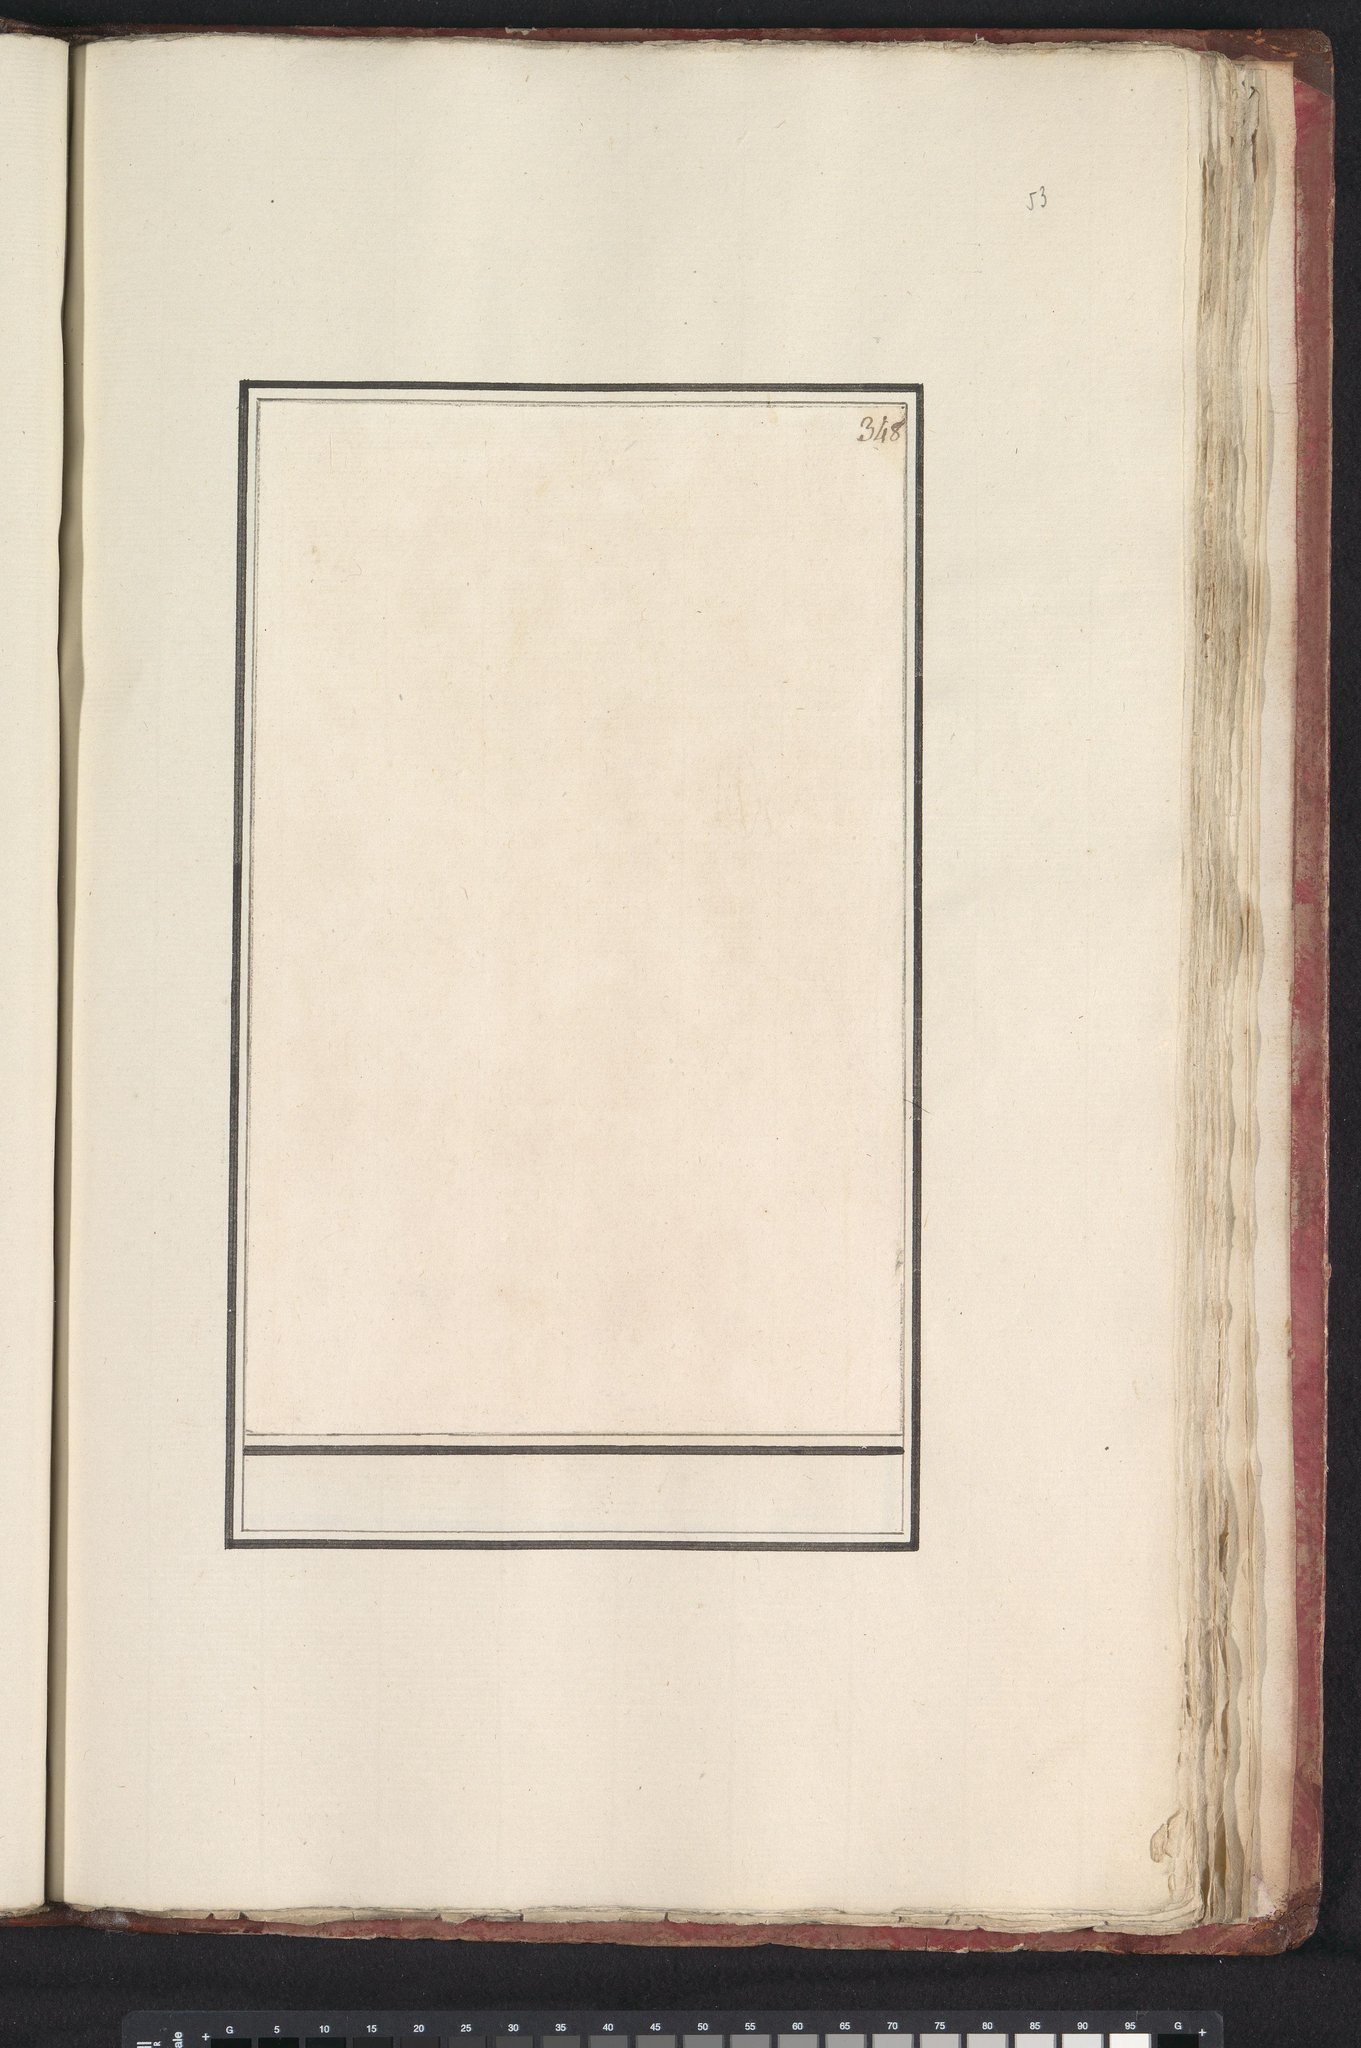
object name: drawing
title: Omlijsting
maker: Anonymous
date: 1809-1814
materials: paper, pencil, watercolor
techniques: brush, pen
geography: southern netherlands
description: Lege omlijsting. Rechtsboven genummerd: 348. Onderdeel van het vierde album met tekeningen van bloemen en paddestoelen. Elfde van twaalf albums met tekeningen van dieren, vogels en planten bekend rond 1600, gemaakt in opdracht van keizer Rudolf II. Met toelichting in Nederlands, Latijn en Frans.